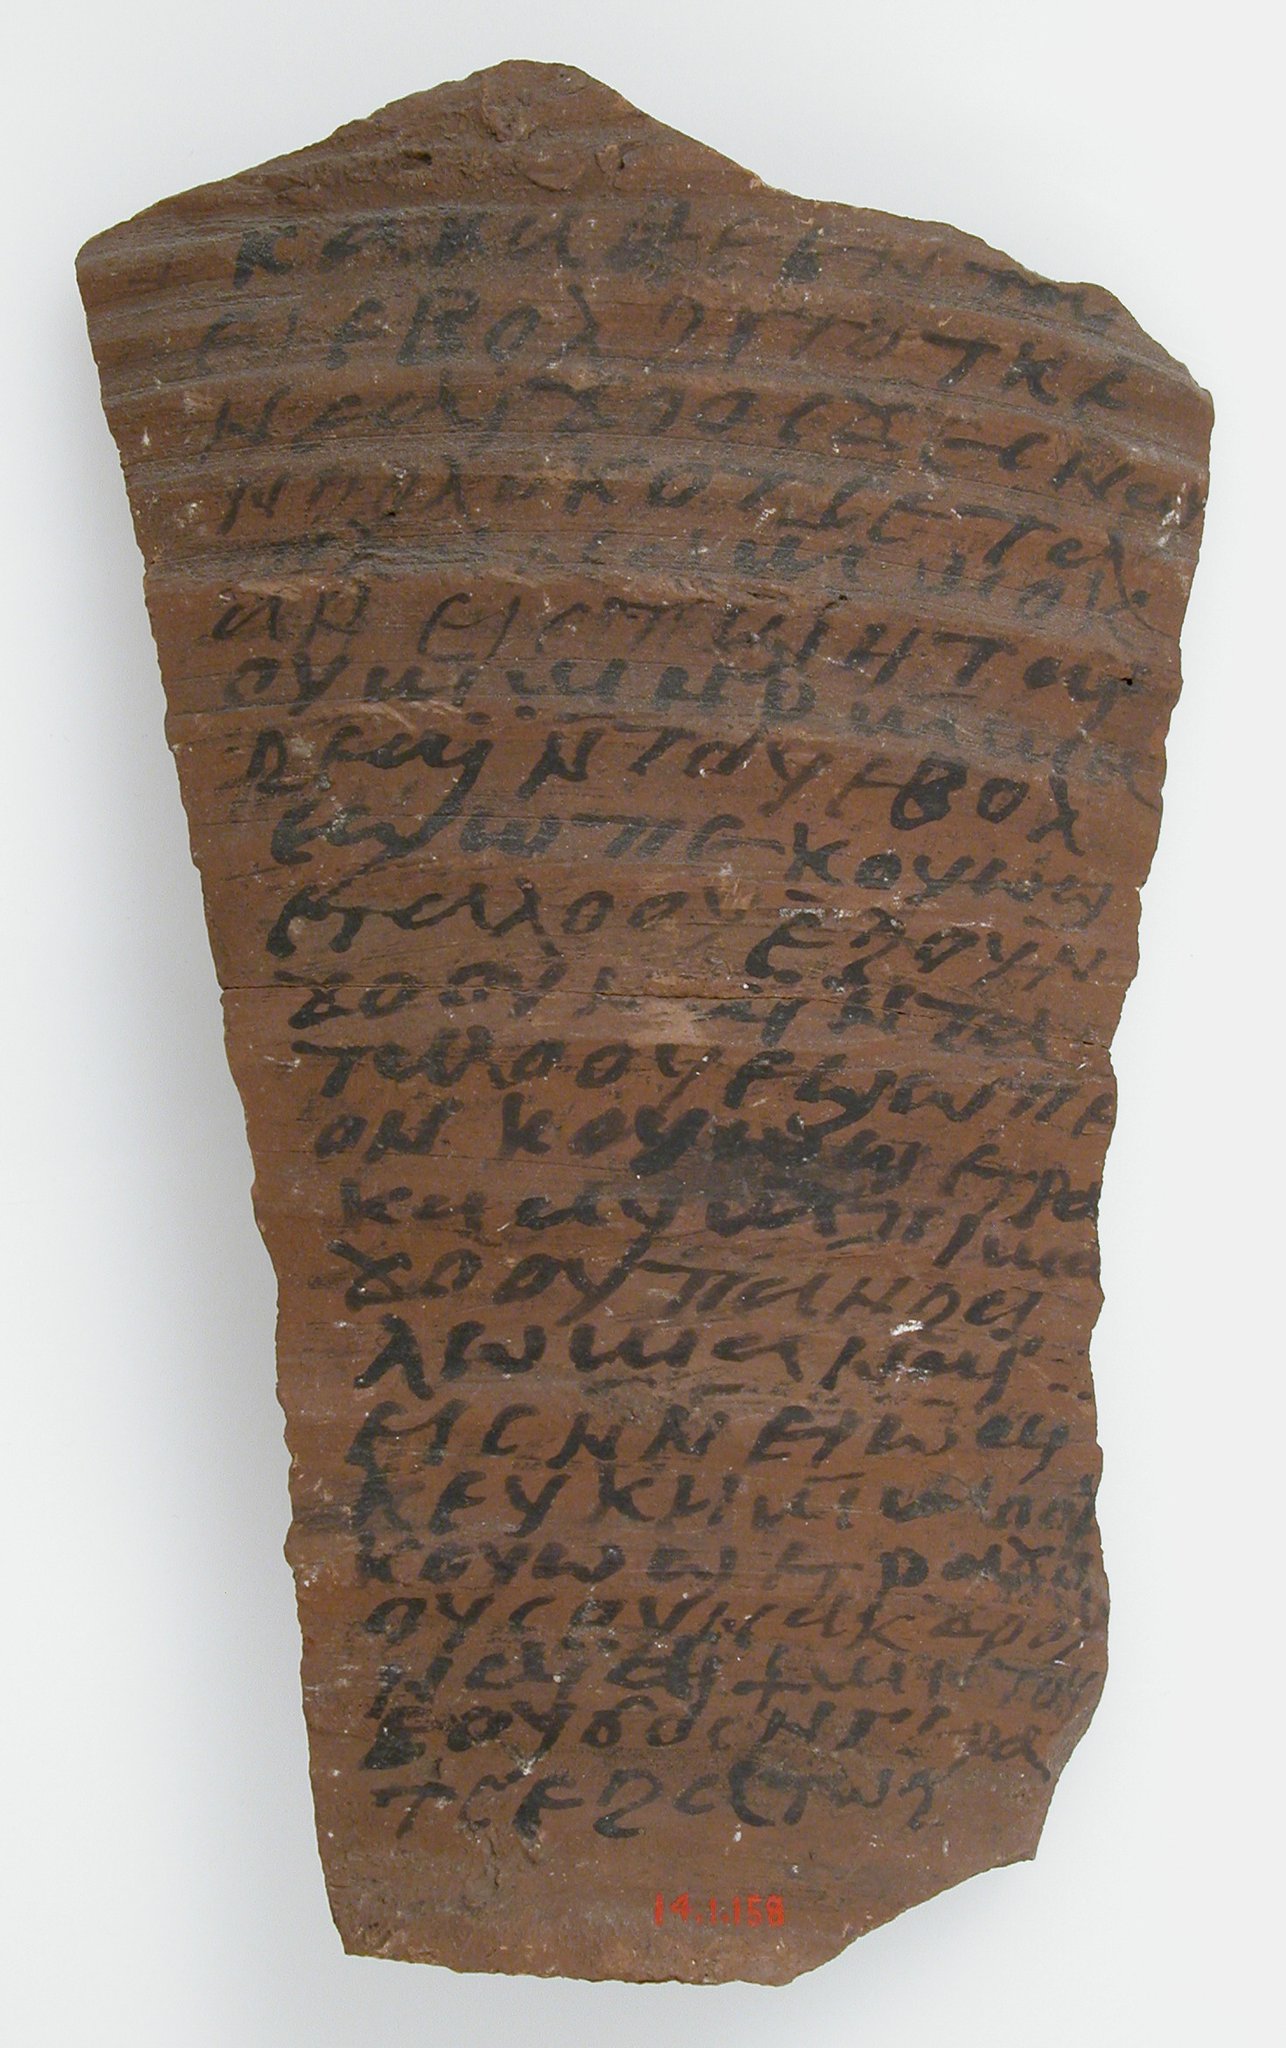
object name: ostrakon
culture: coptic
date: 580-640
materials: ink, pottery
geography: egypt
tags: coptic,documents